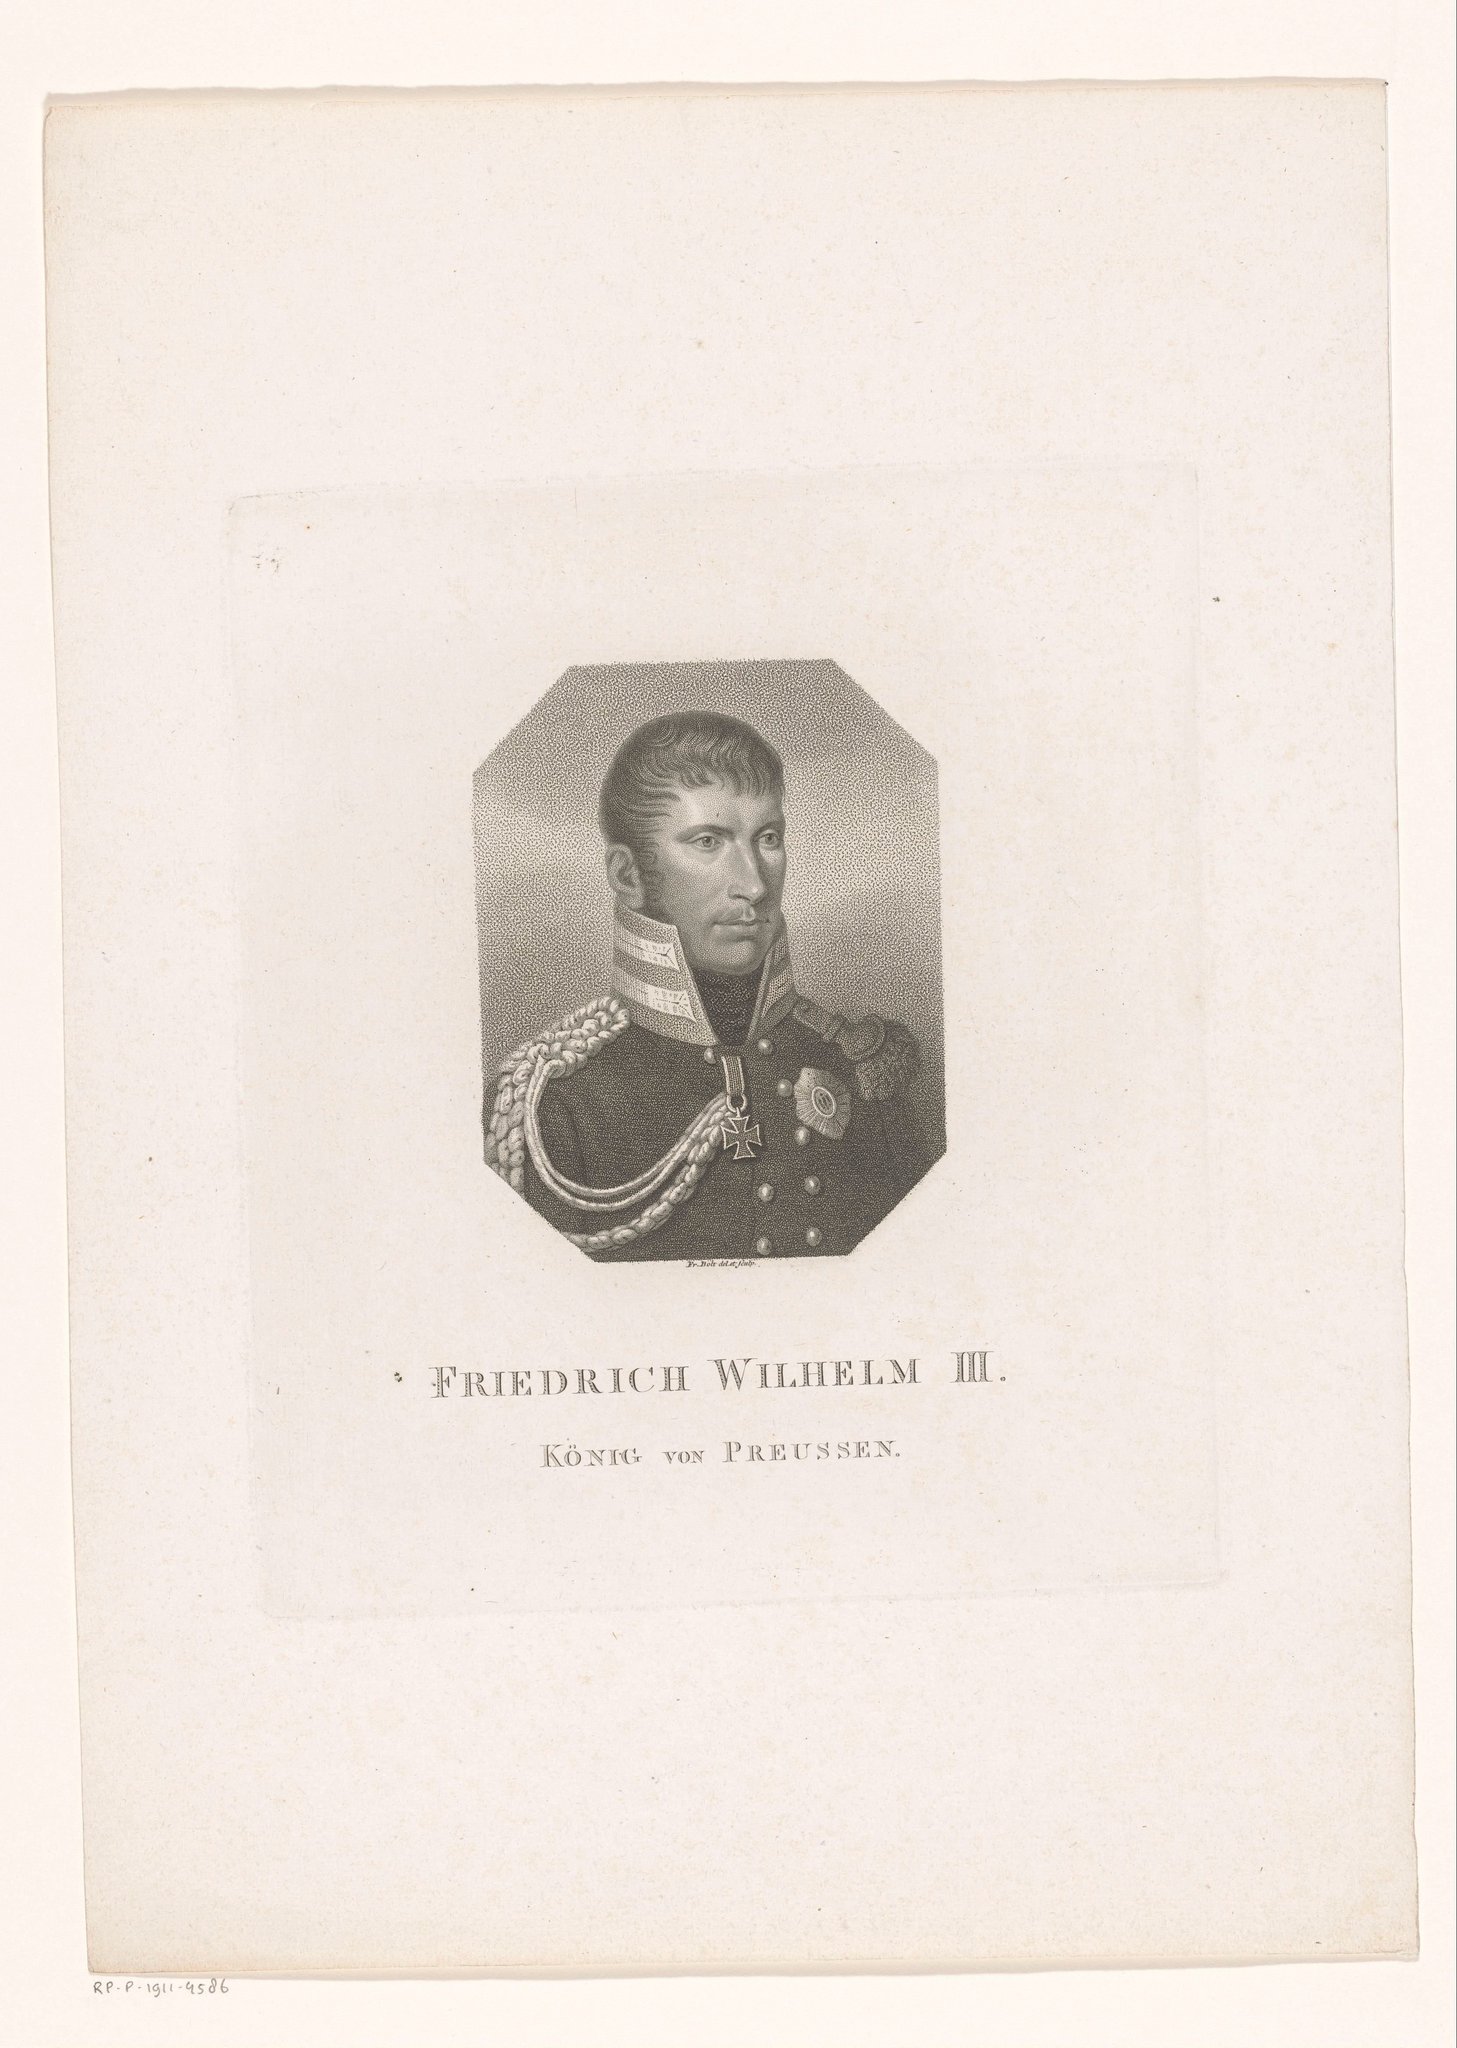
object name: print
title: Portret Friedrich Wilhelm III van Pruissen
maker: johann friedrich bolt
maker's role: print maker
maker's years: 1769-1836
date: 1817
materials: paper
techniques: stippling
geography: berlin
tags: berlin, frederik willem iii koning van pruisen, knighthood order (with name) - insignia of a knighthood order, e.g.: badge, chain (with name of order), historical persons, (military) uniforms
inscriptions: collector's mark: Lugt 2228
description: : Erinnerungsbuch für Alle, welche in den Jahren 1813, 1814, 1815 Theil genommen haben an dem heiligen Kampf um Selbständigkeit und Freiheit.